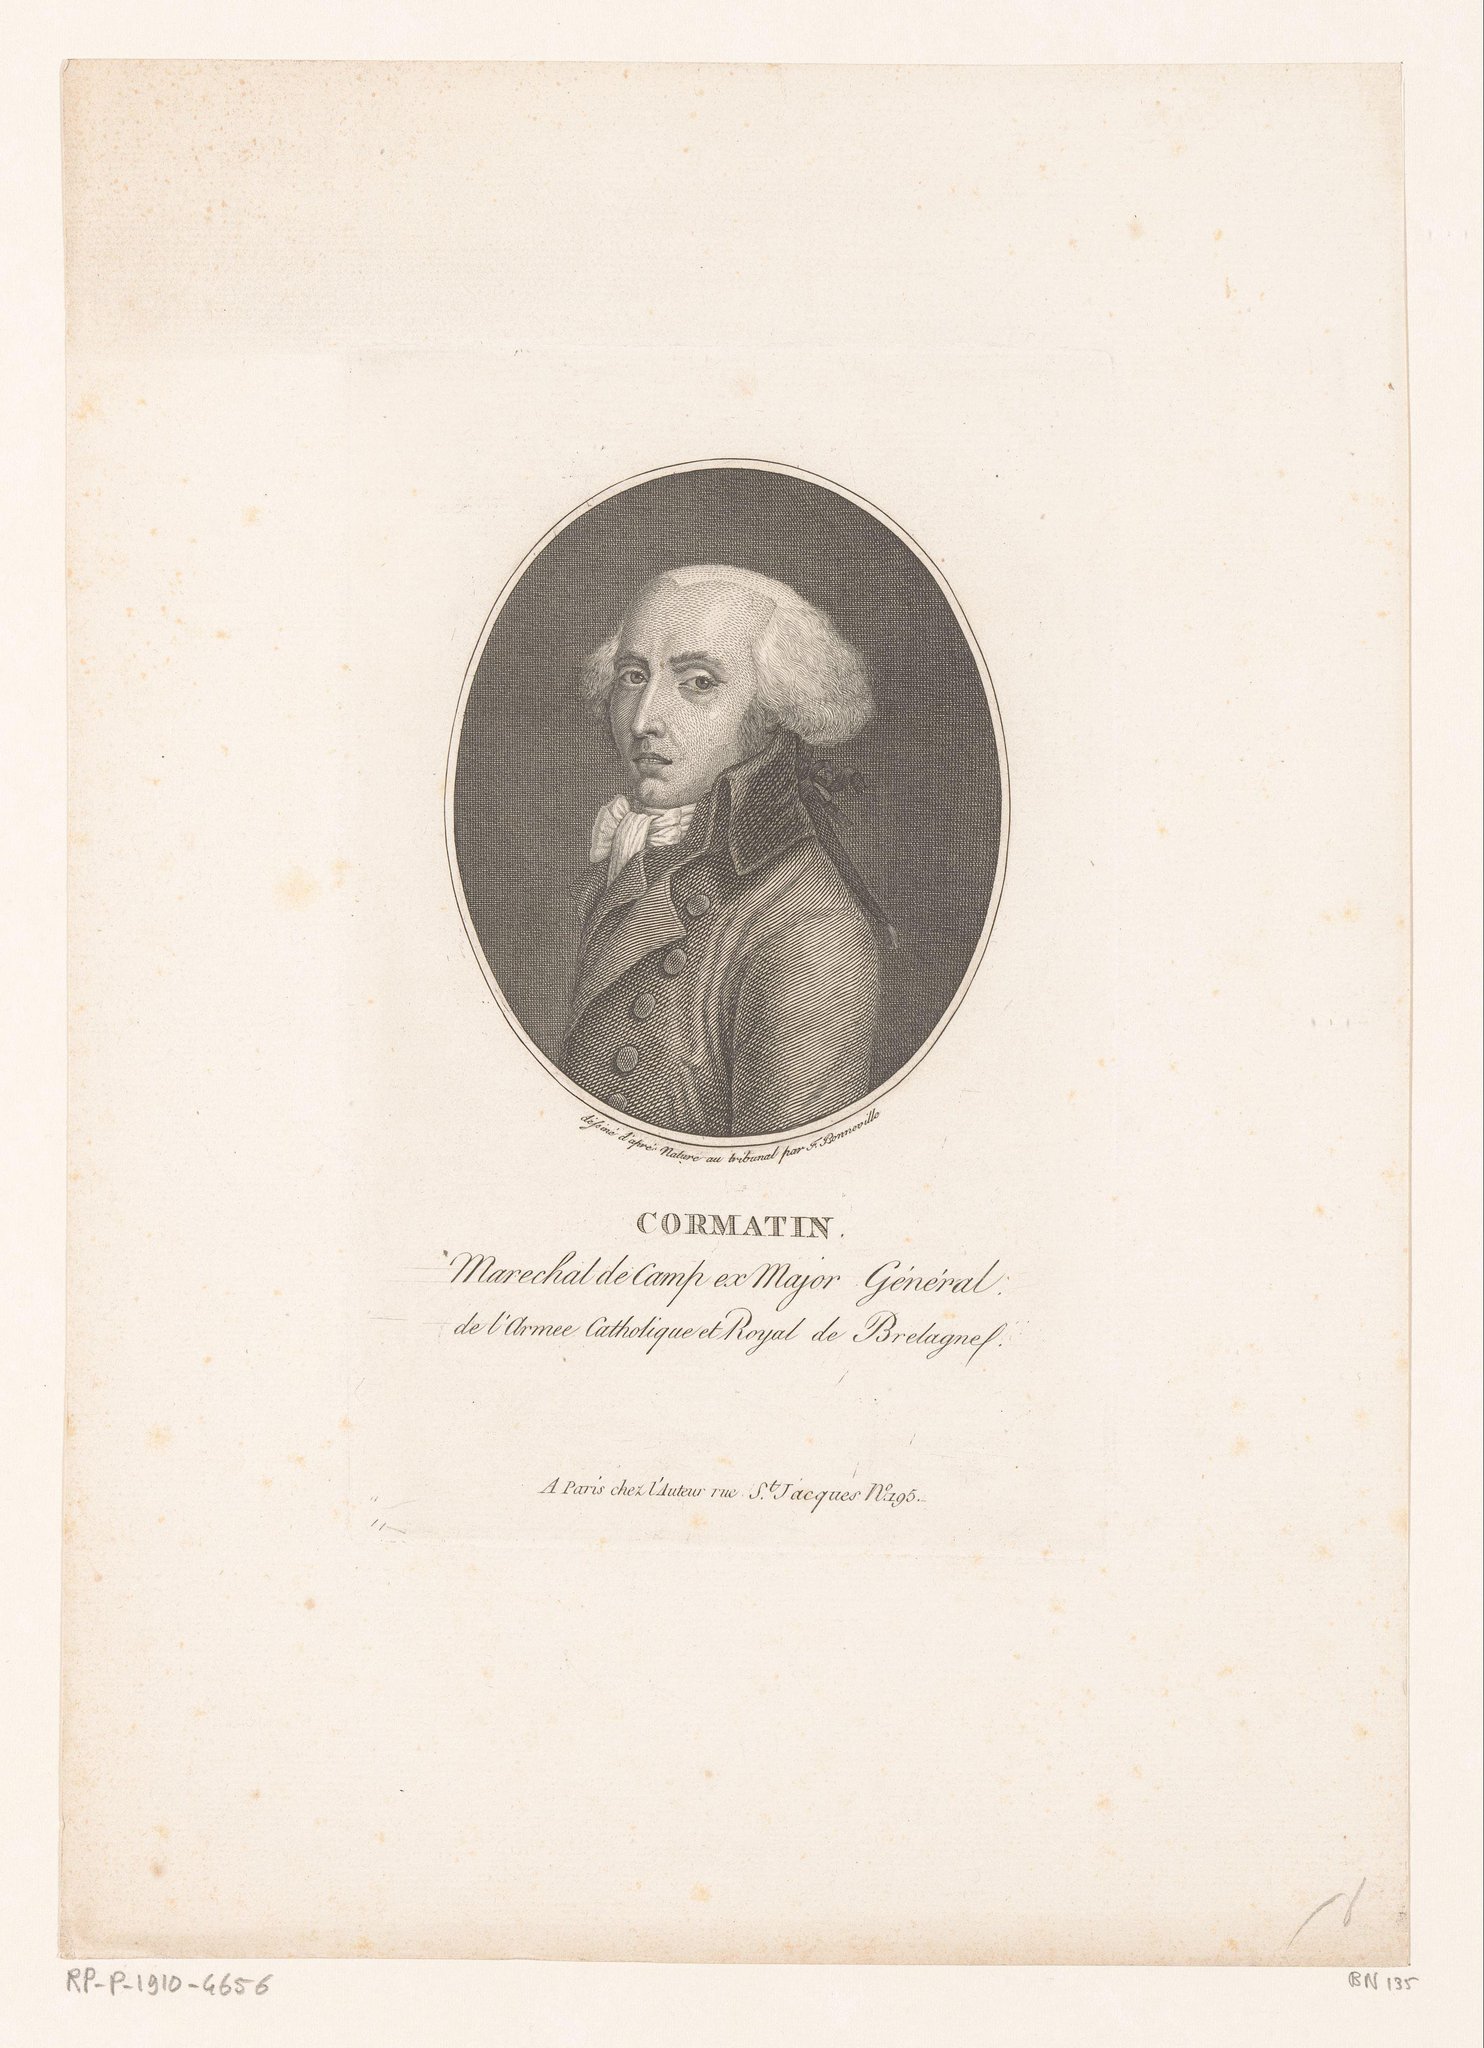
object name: print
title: Portret van Pierre Dezoteux de Cormatin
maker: françois bonneville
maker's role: draughtsman, painter, print maker, publisher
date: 1796-1802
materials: paper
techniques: engraving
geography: paris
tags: paris, commander-in-chief, general, marshal, historical persons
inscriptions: collector's mark: Lugt 2228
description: Maakt deel uit van een serie getiteld: Portraits des personnages célèbres de la Révolution (...), uitgegeven tussen 1796-1802.